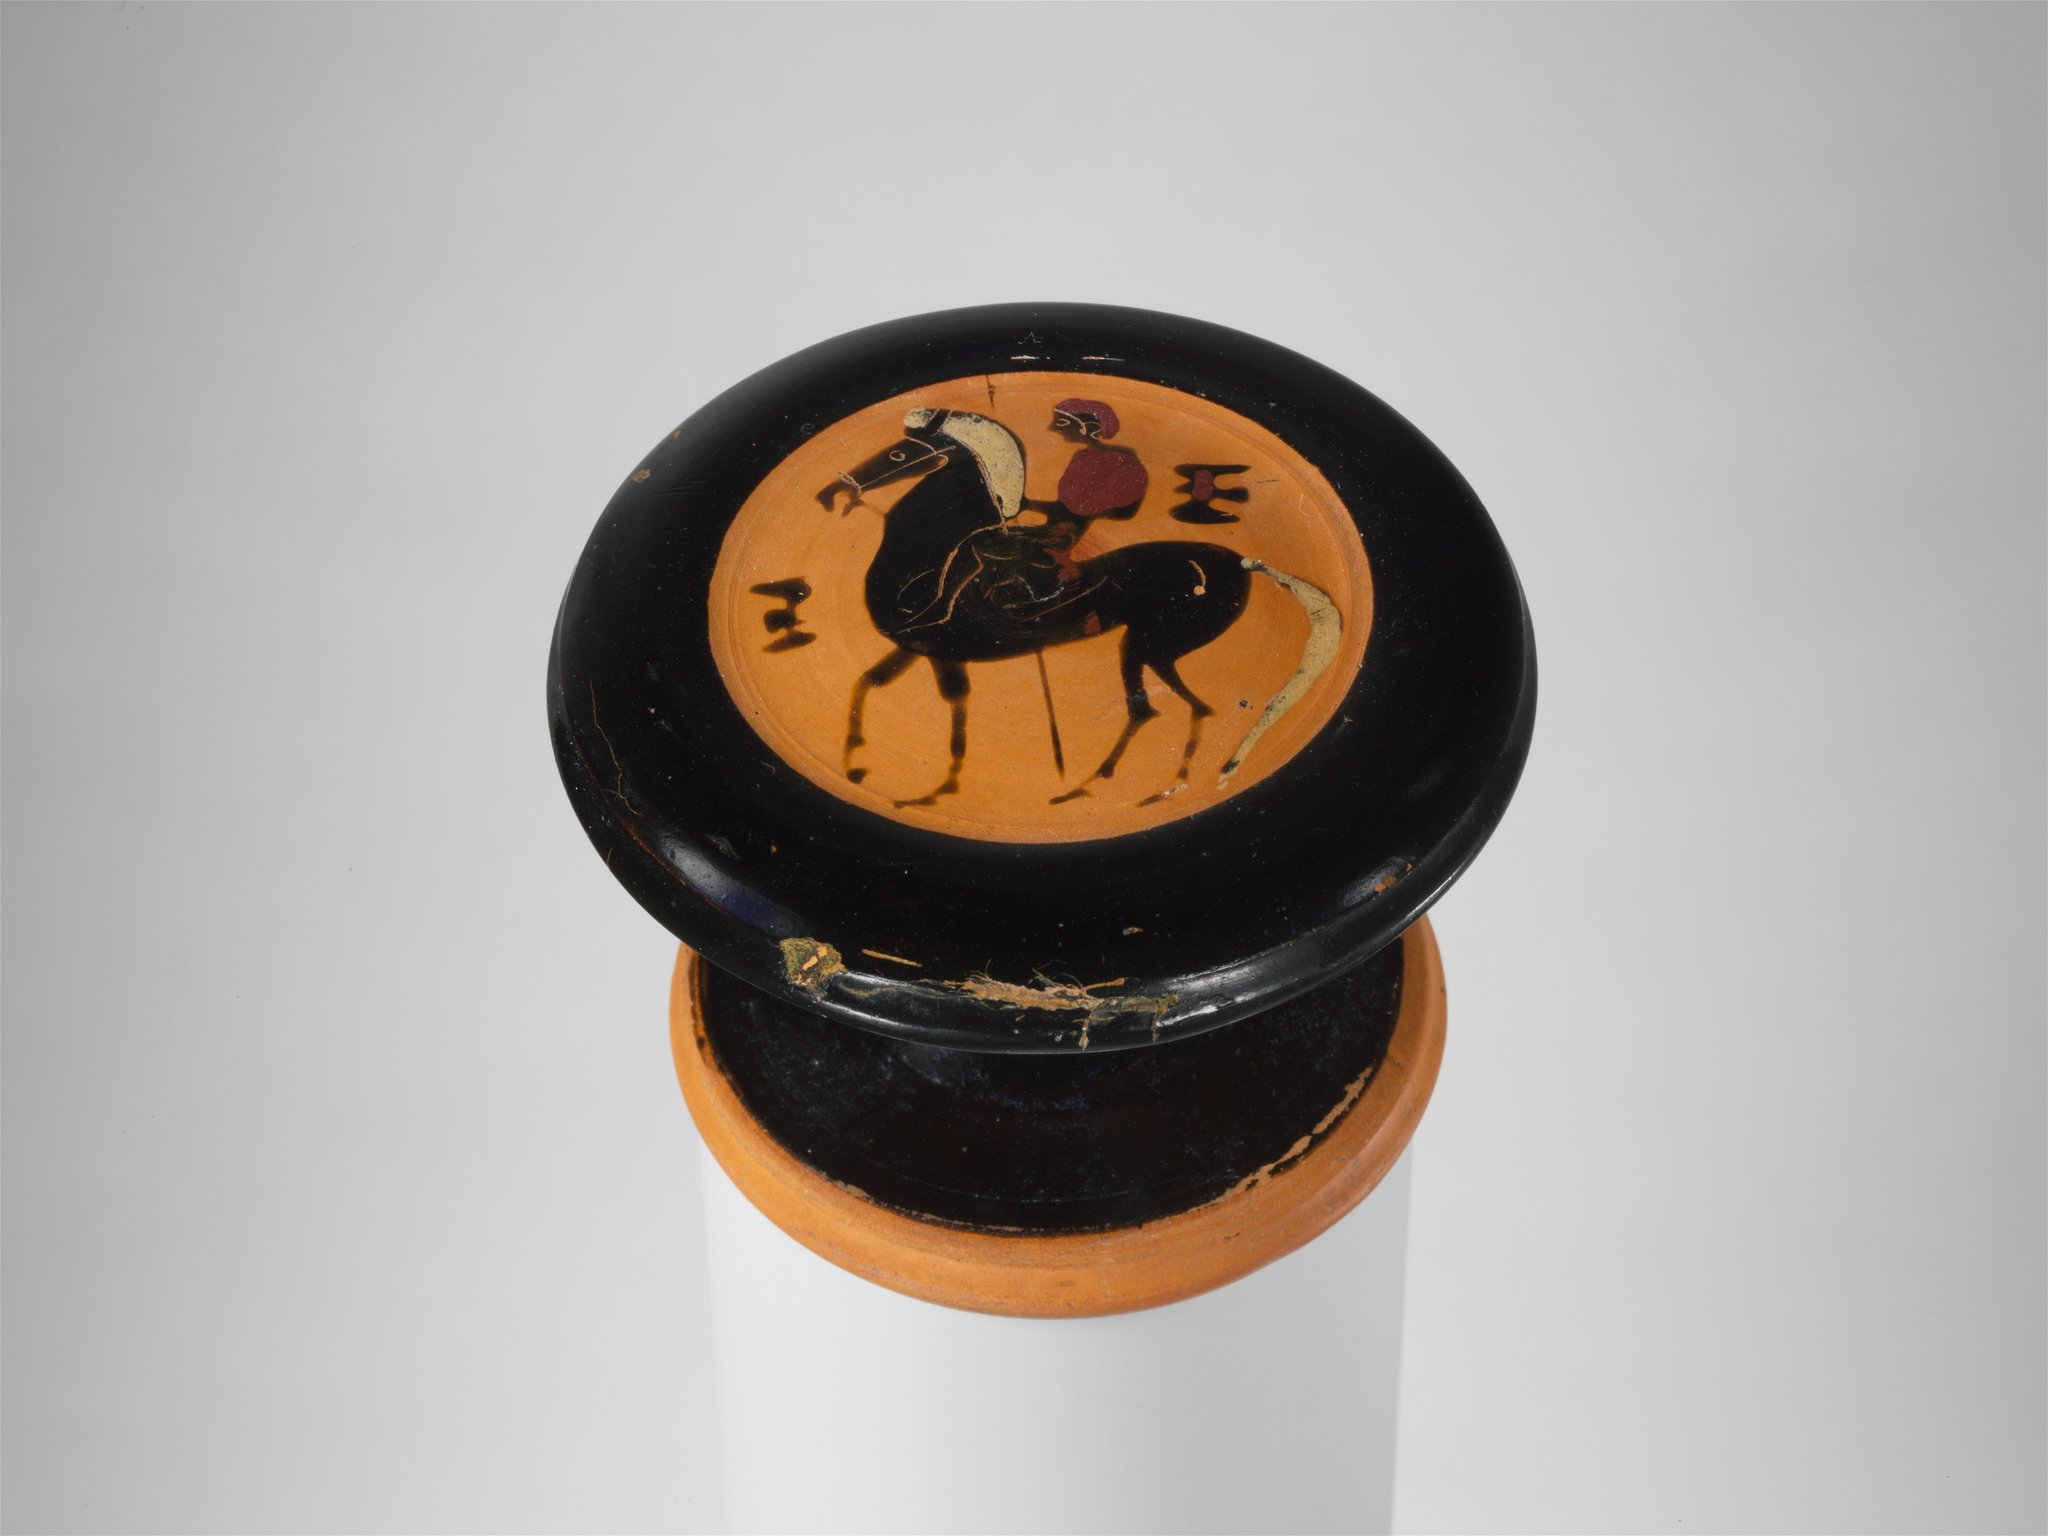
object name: stand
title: Terracotta standlet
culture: greek, attic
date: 520-500 BCE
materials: terracotta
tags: men,horses